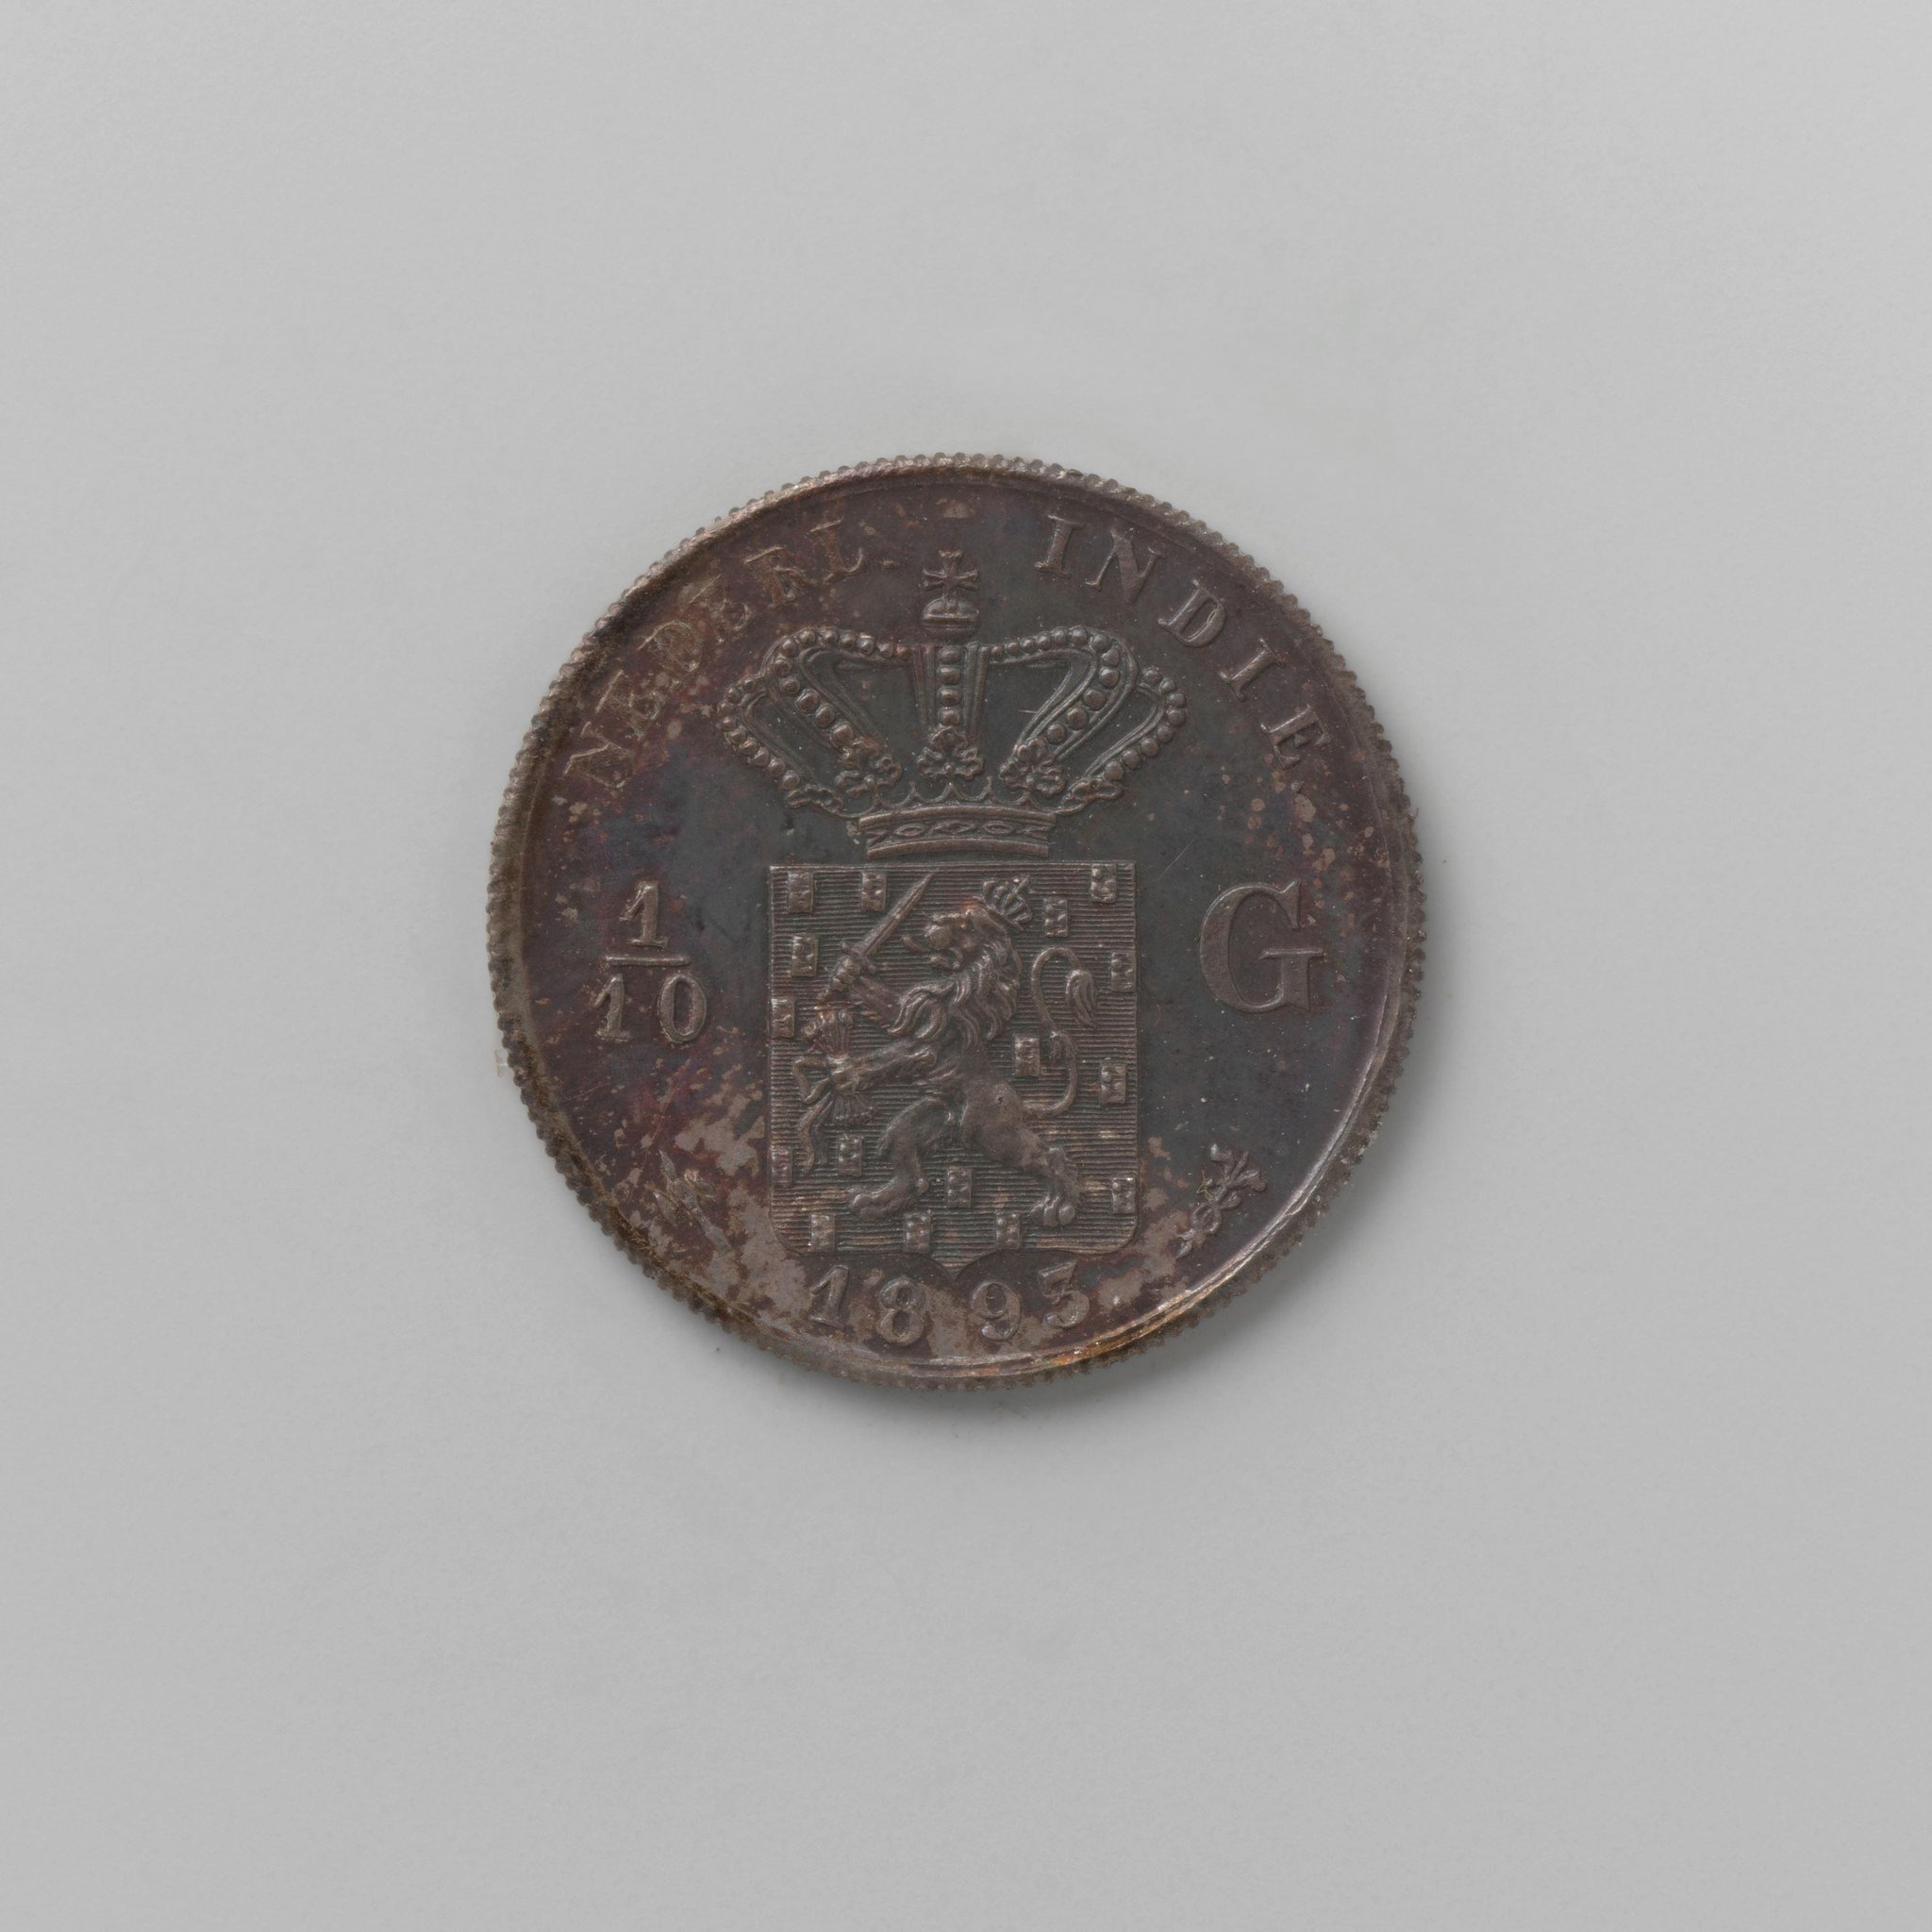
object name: coin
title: Nederlands Indië,1/10 gulden,1893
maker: wilhelmina of the netherlands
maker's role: print maker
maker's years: 1880-1962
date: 1893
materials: copper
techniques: striking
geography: utrecht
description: Zilveren munt. Voorzijde: tussen waarde-aanduiding 1/10 G gekroond rijkswapenschild. Boven kroon landsaanduiding en onder wapenschild jaartal. Keerzijde: tweeregelig Maleis opschrift in Arabische tekens, waaromheen omschrift in het Javaans. Kartelrand.